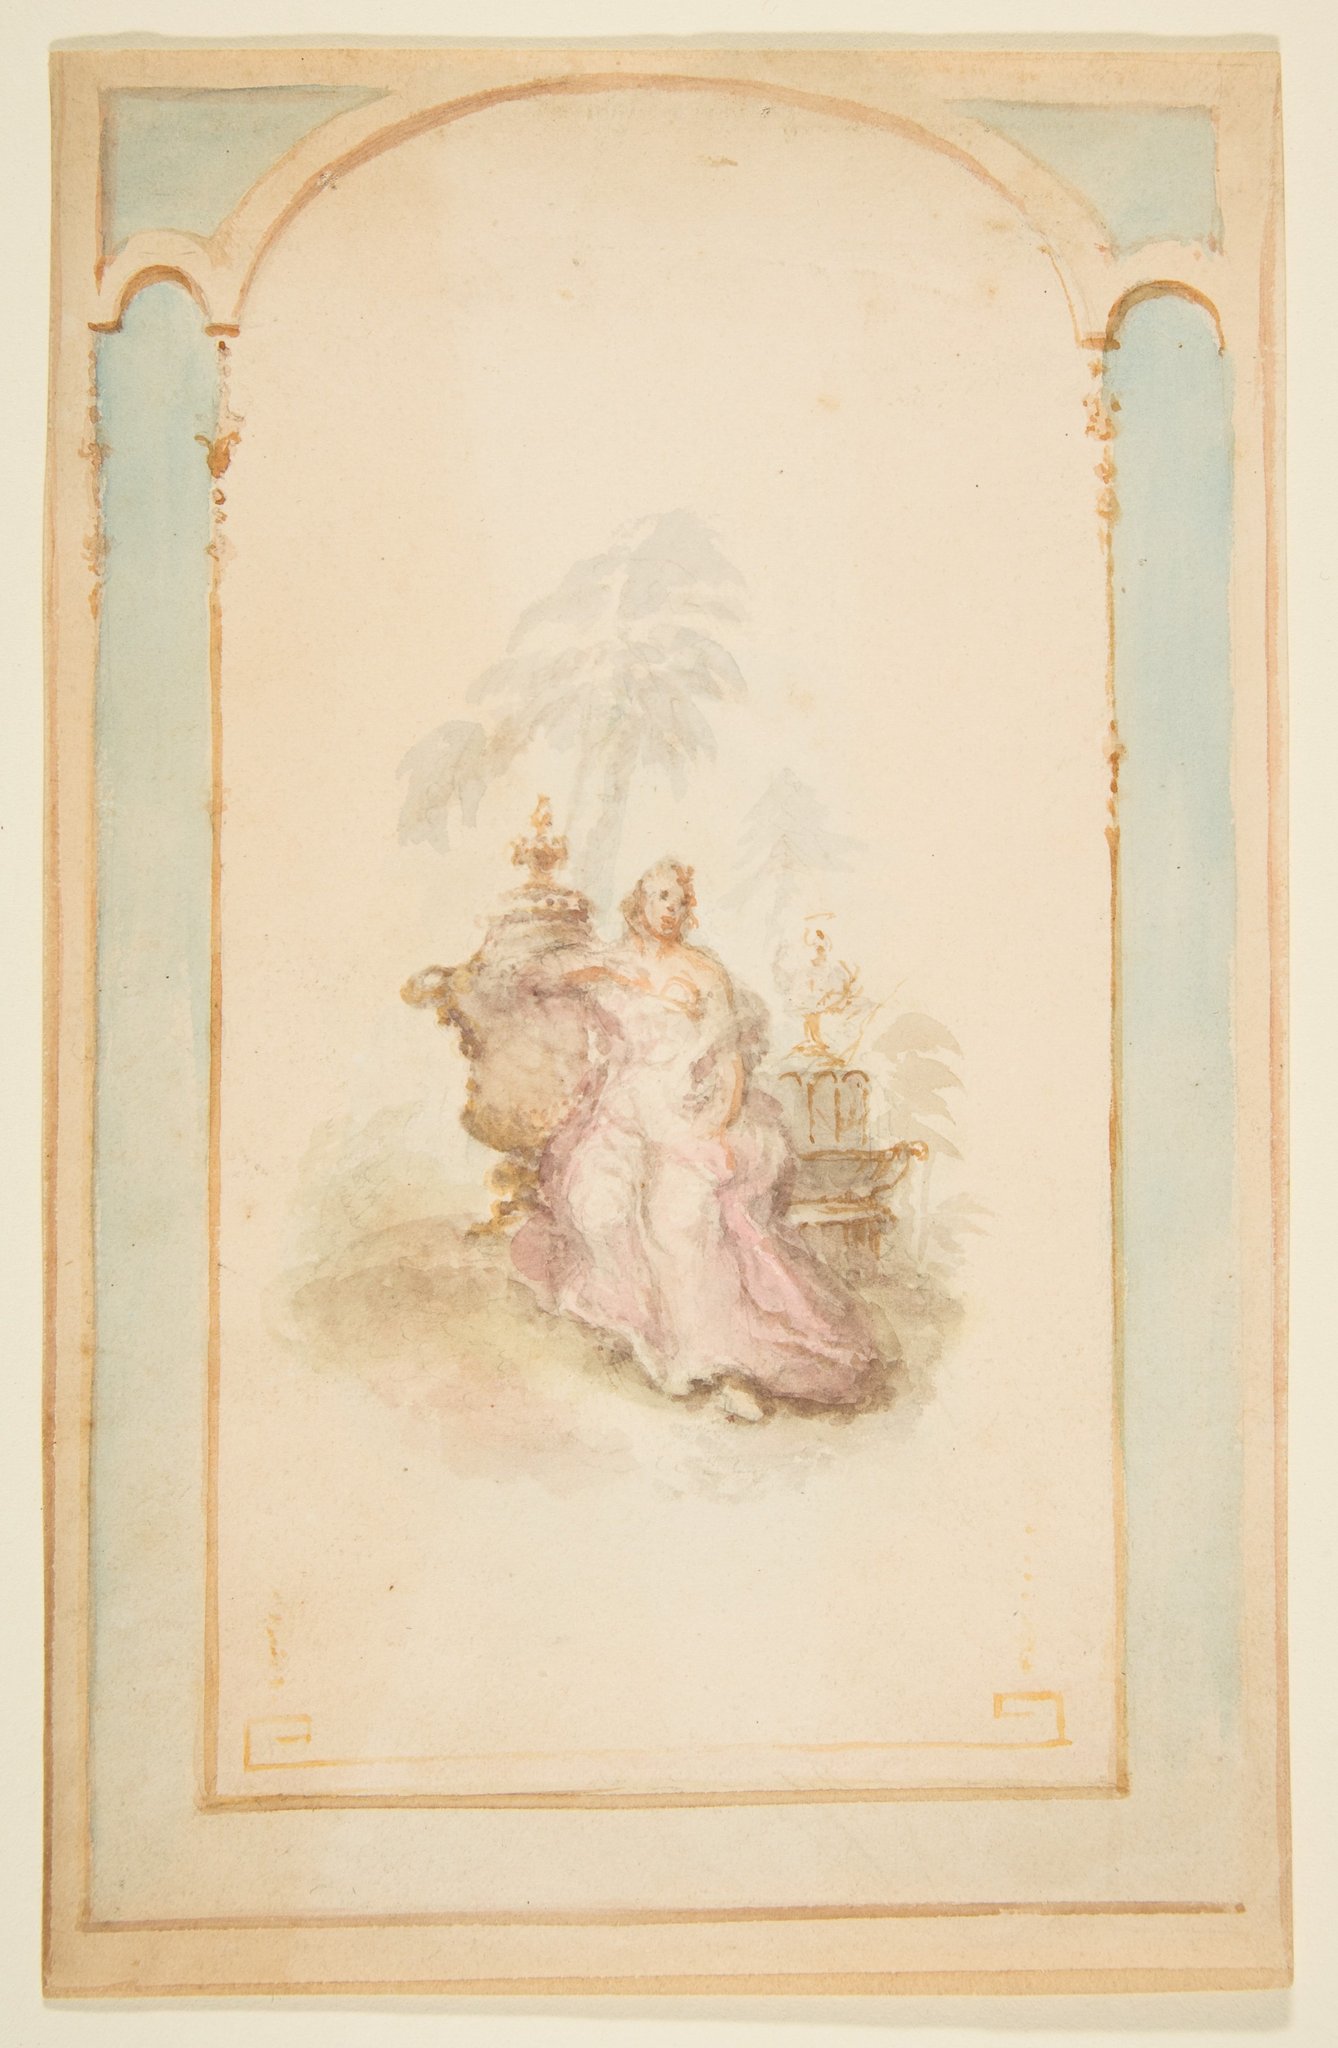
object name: drawing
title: Ornament Design for Wall Panel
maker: anonymous, french, 19th century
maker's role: artist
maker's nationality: french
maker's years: 1800-1900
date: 1801-1900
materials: watercolor, paper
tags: women